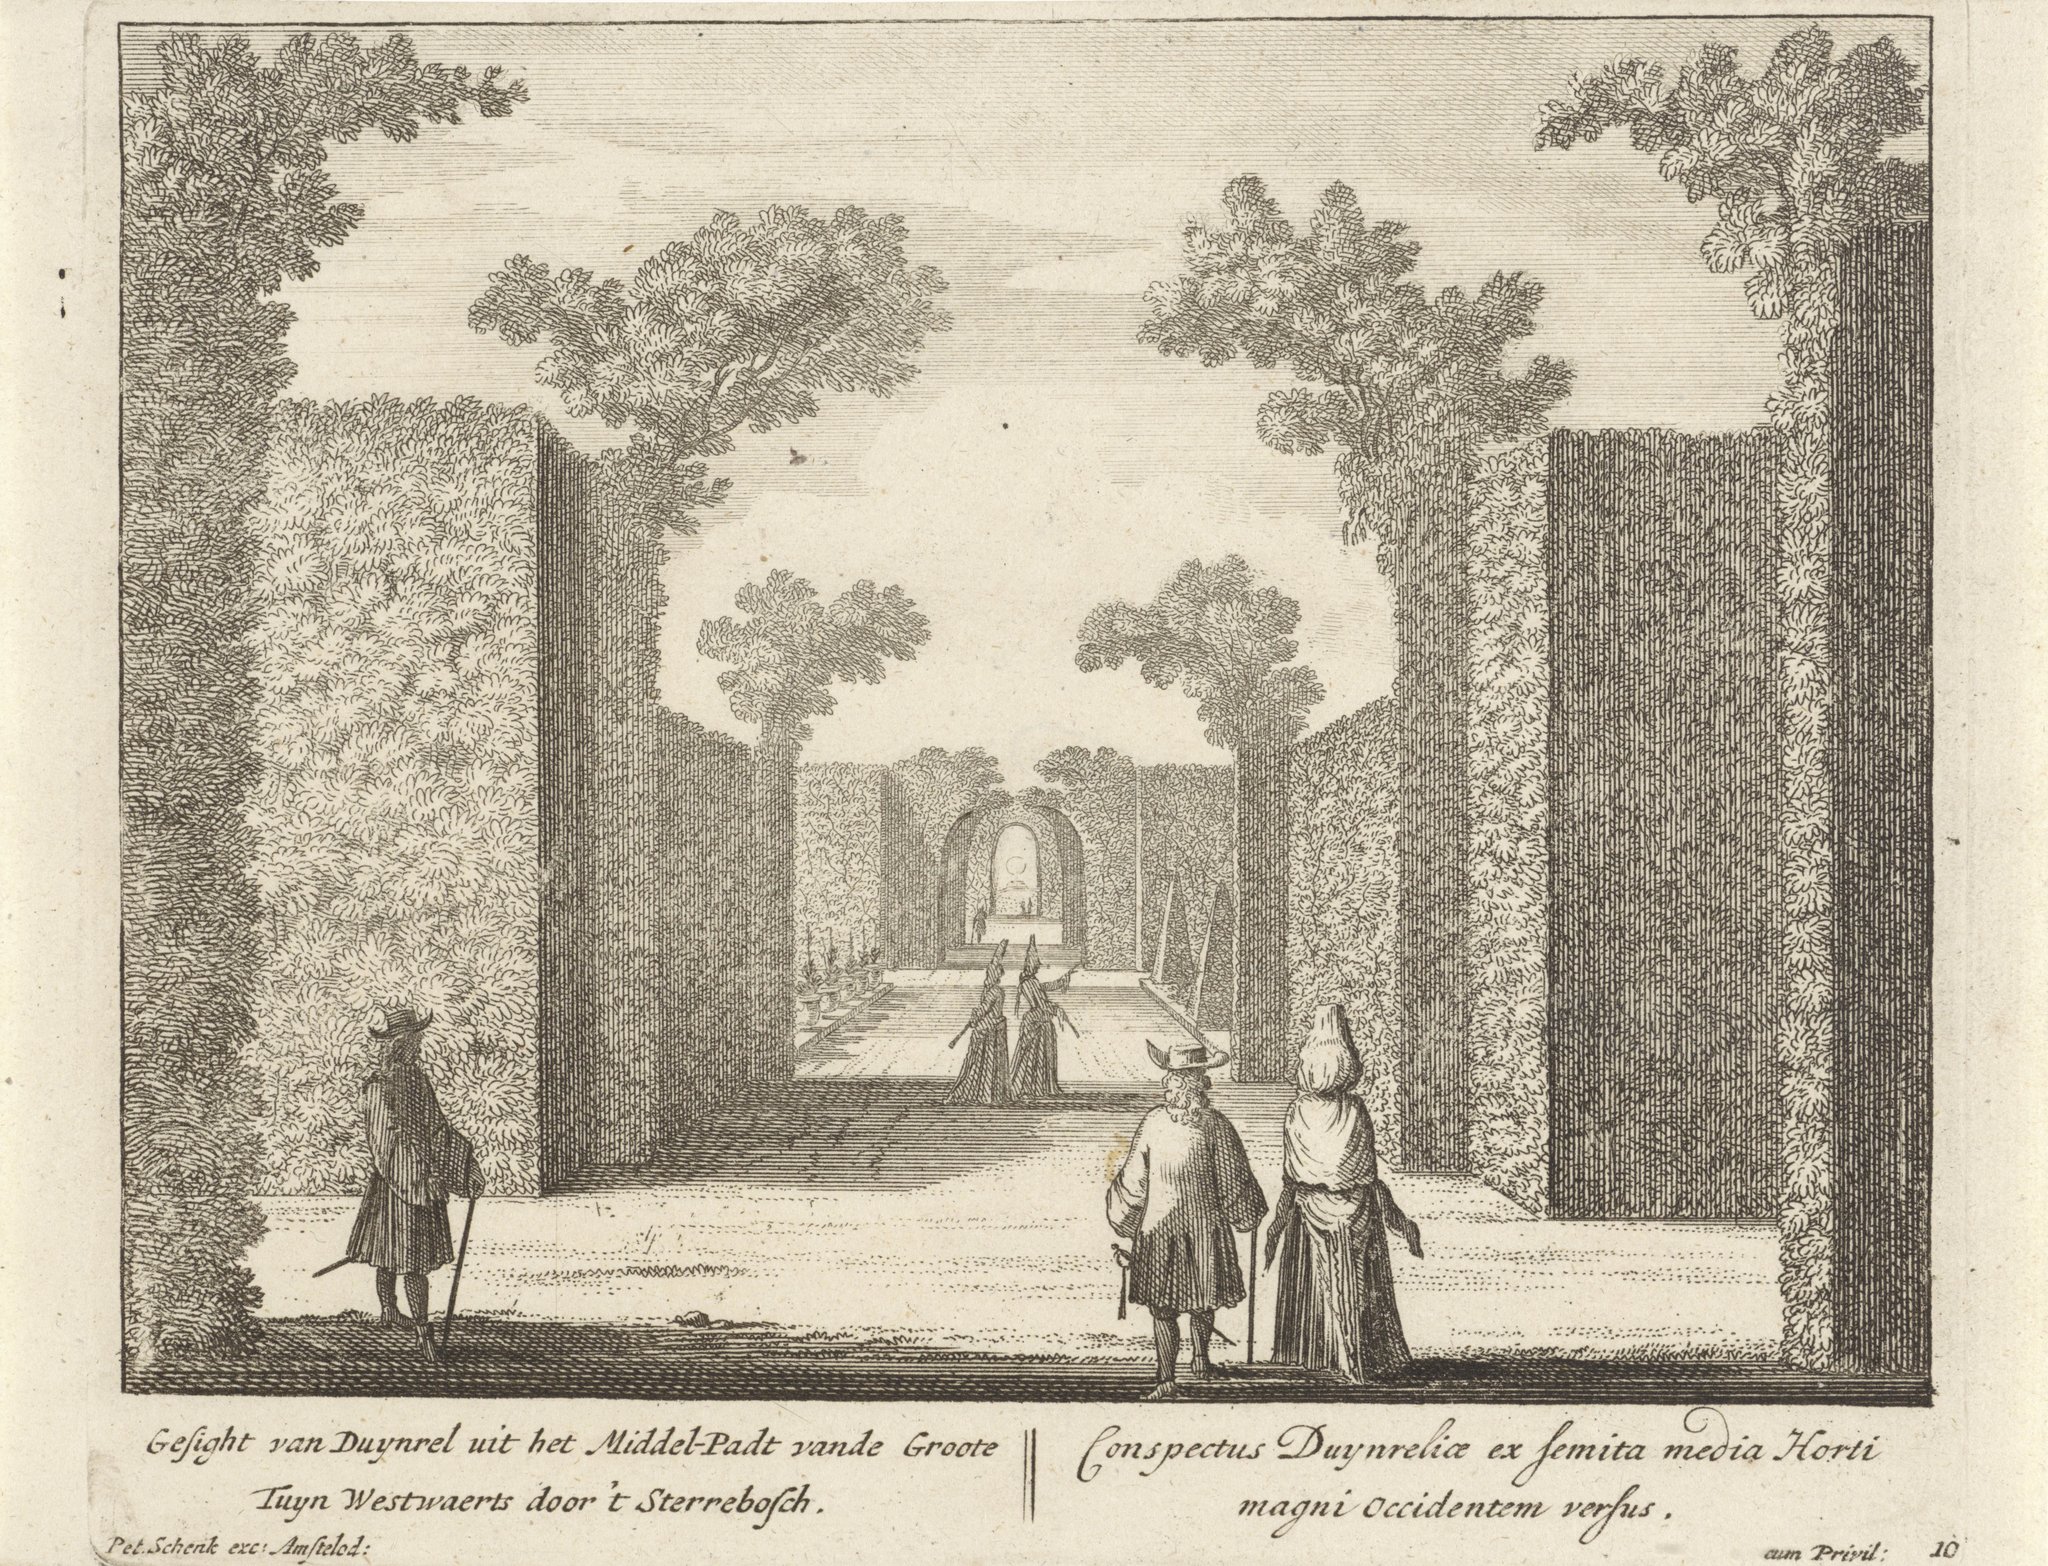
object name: print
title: Gezichten op de buitenplaats Duinrell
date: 1675-1711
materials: paper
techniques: engraving, etching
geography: amsterdam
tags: french or architectonic garden; formal garden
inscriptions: collector's mark: Lugt 2228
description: Gezicht op het sterrenbos in de tuin van buitenplaats Duinrell, gezien richting het westen. In het midden het middenpad van de tuin met enkele figuren. Rechtsonder genummerd: 10. Prent uit een serie van zestien prenten van Duinrell.